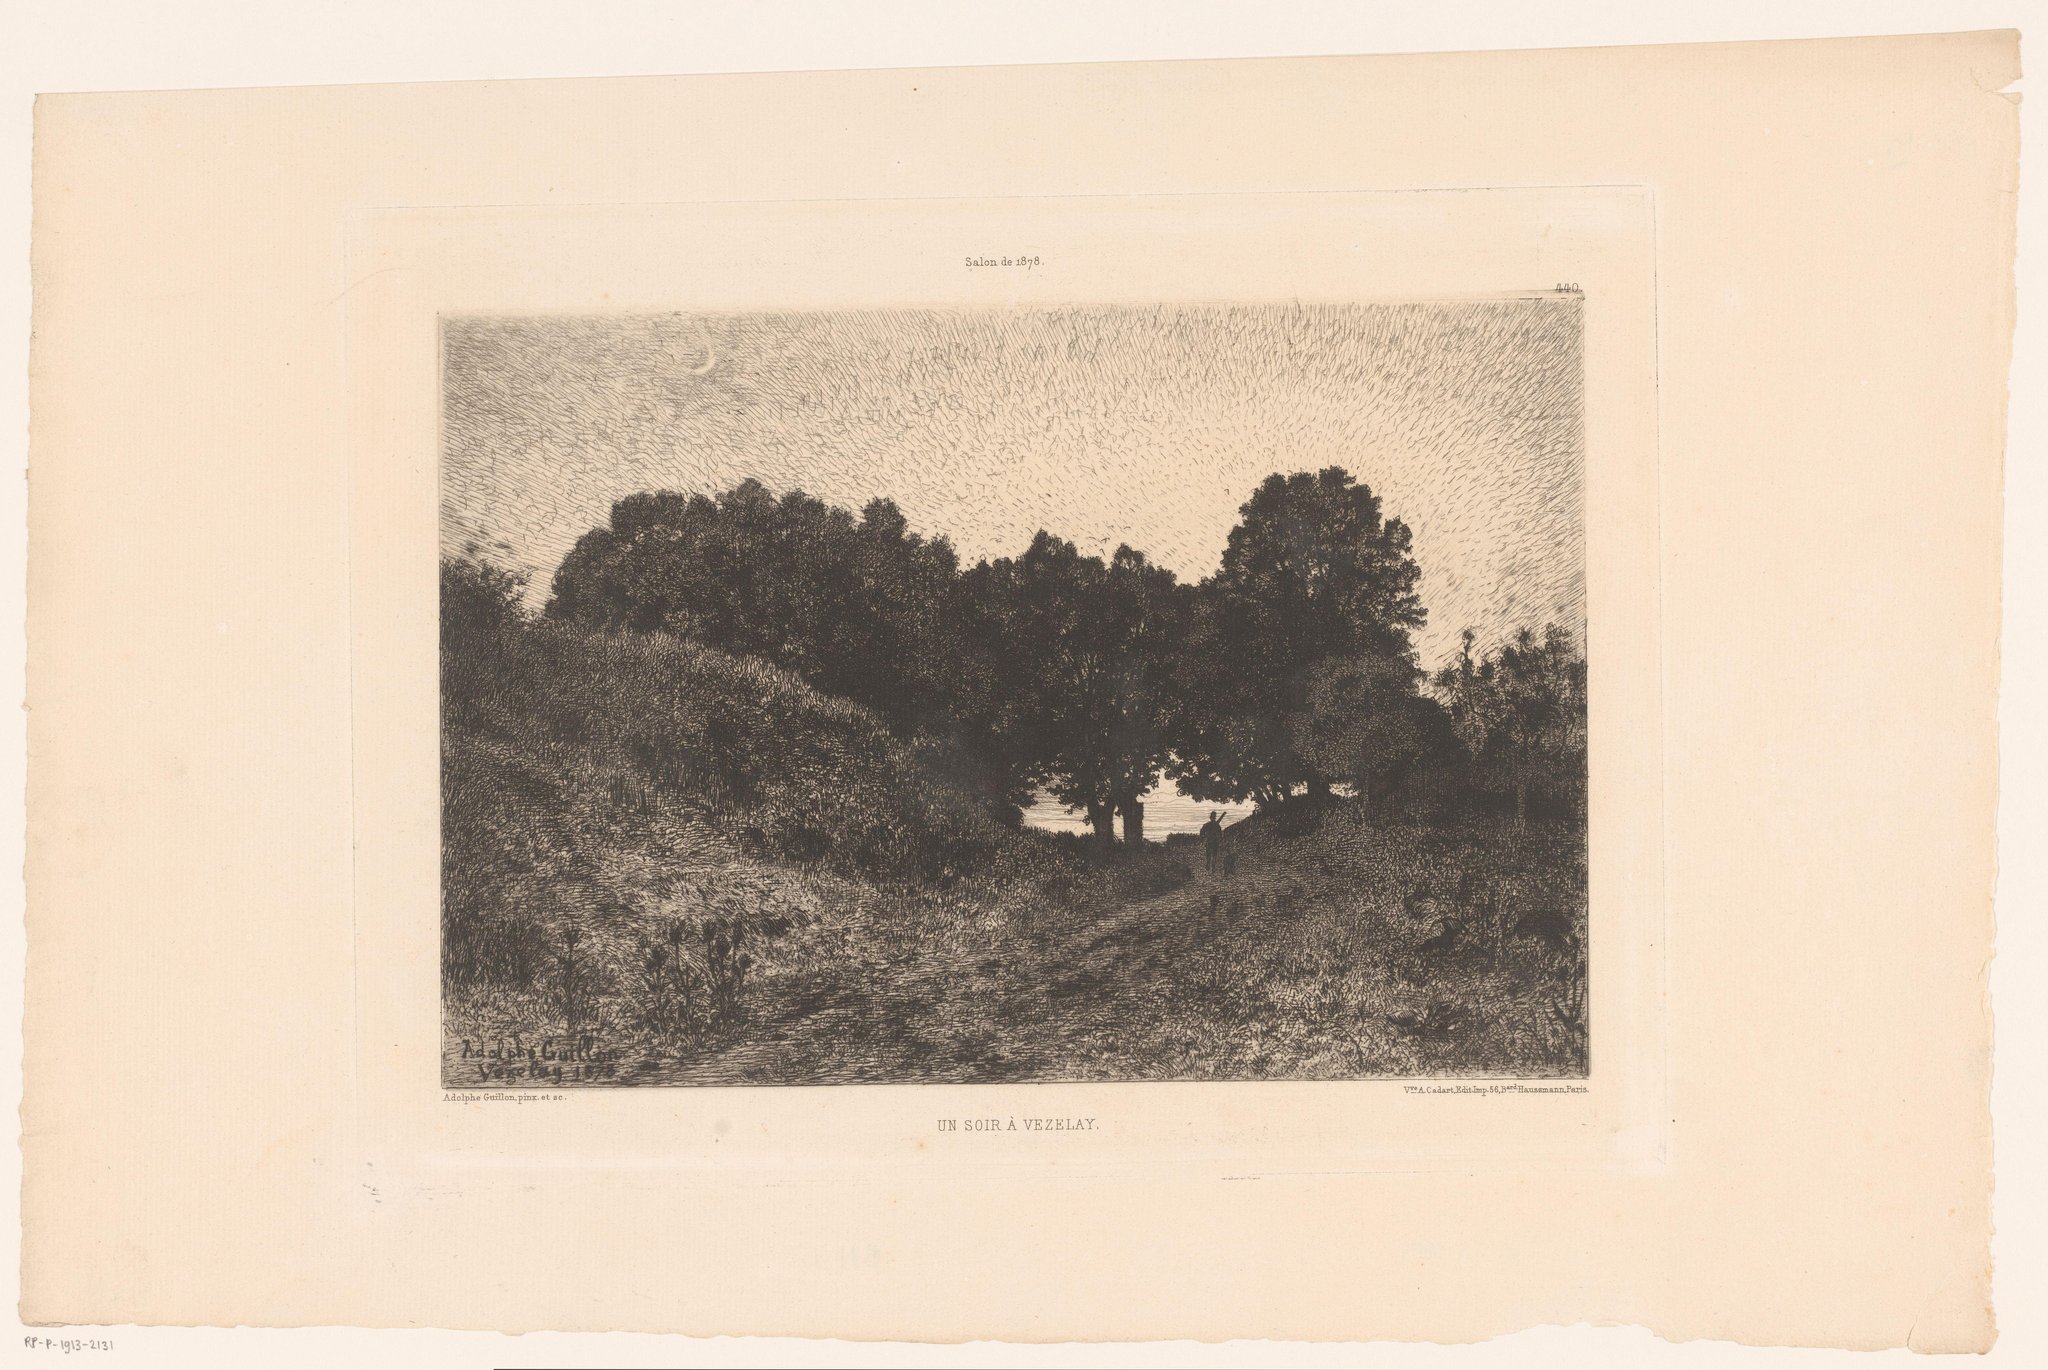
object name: print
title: Gezicht op een landschap bij Vézelay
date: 1878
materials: paper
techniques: etching, intaglio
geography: paris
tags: hunter, forest, wood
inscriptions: collector's mark: Lugt 2233